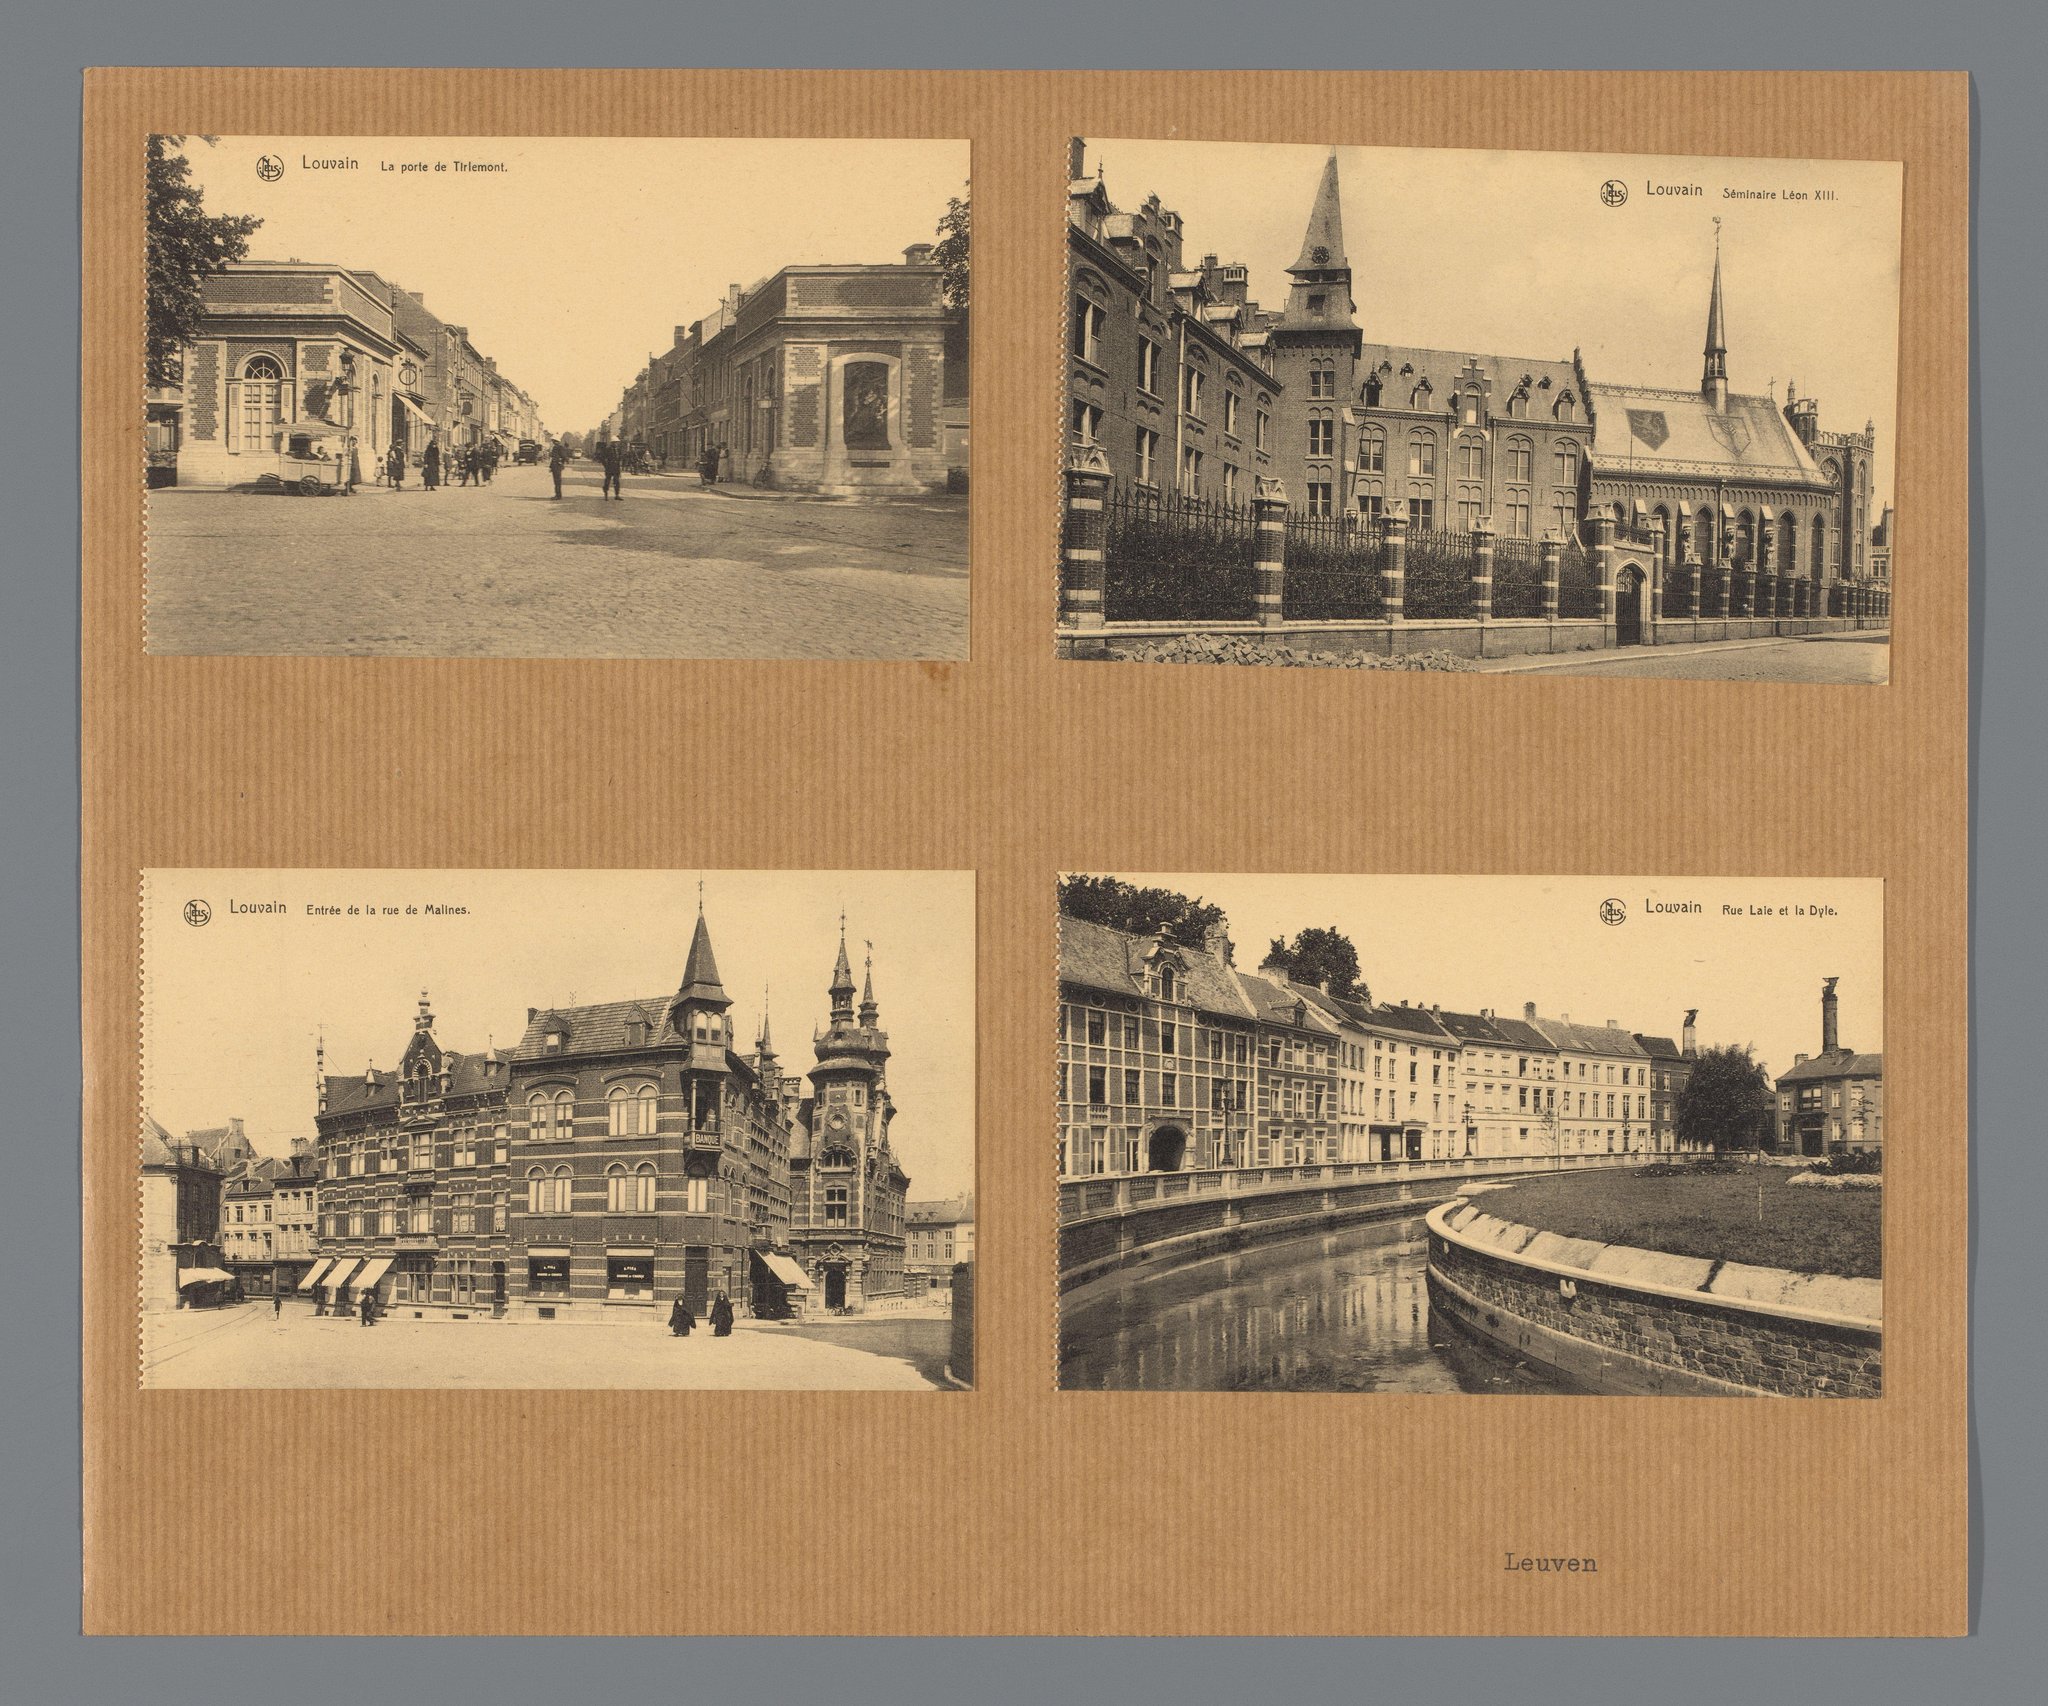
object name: photograph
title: Leuven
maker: Anonymous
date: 1860-1925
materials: photographic support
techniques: photograph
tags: louvain